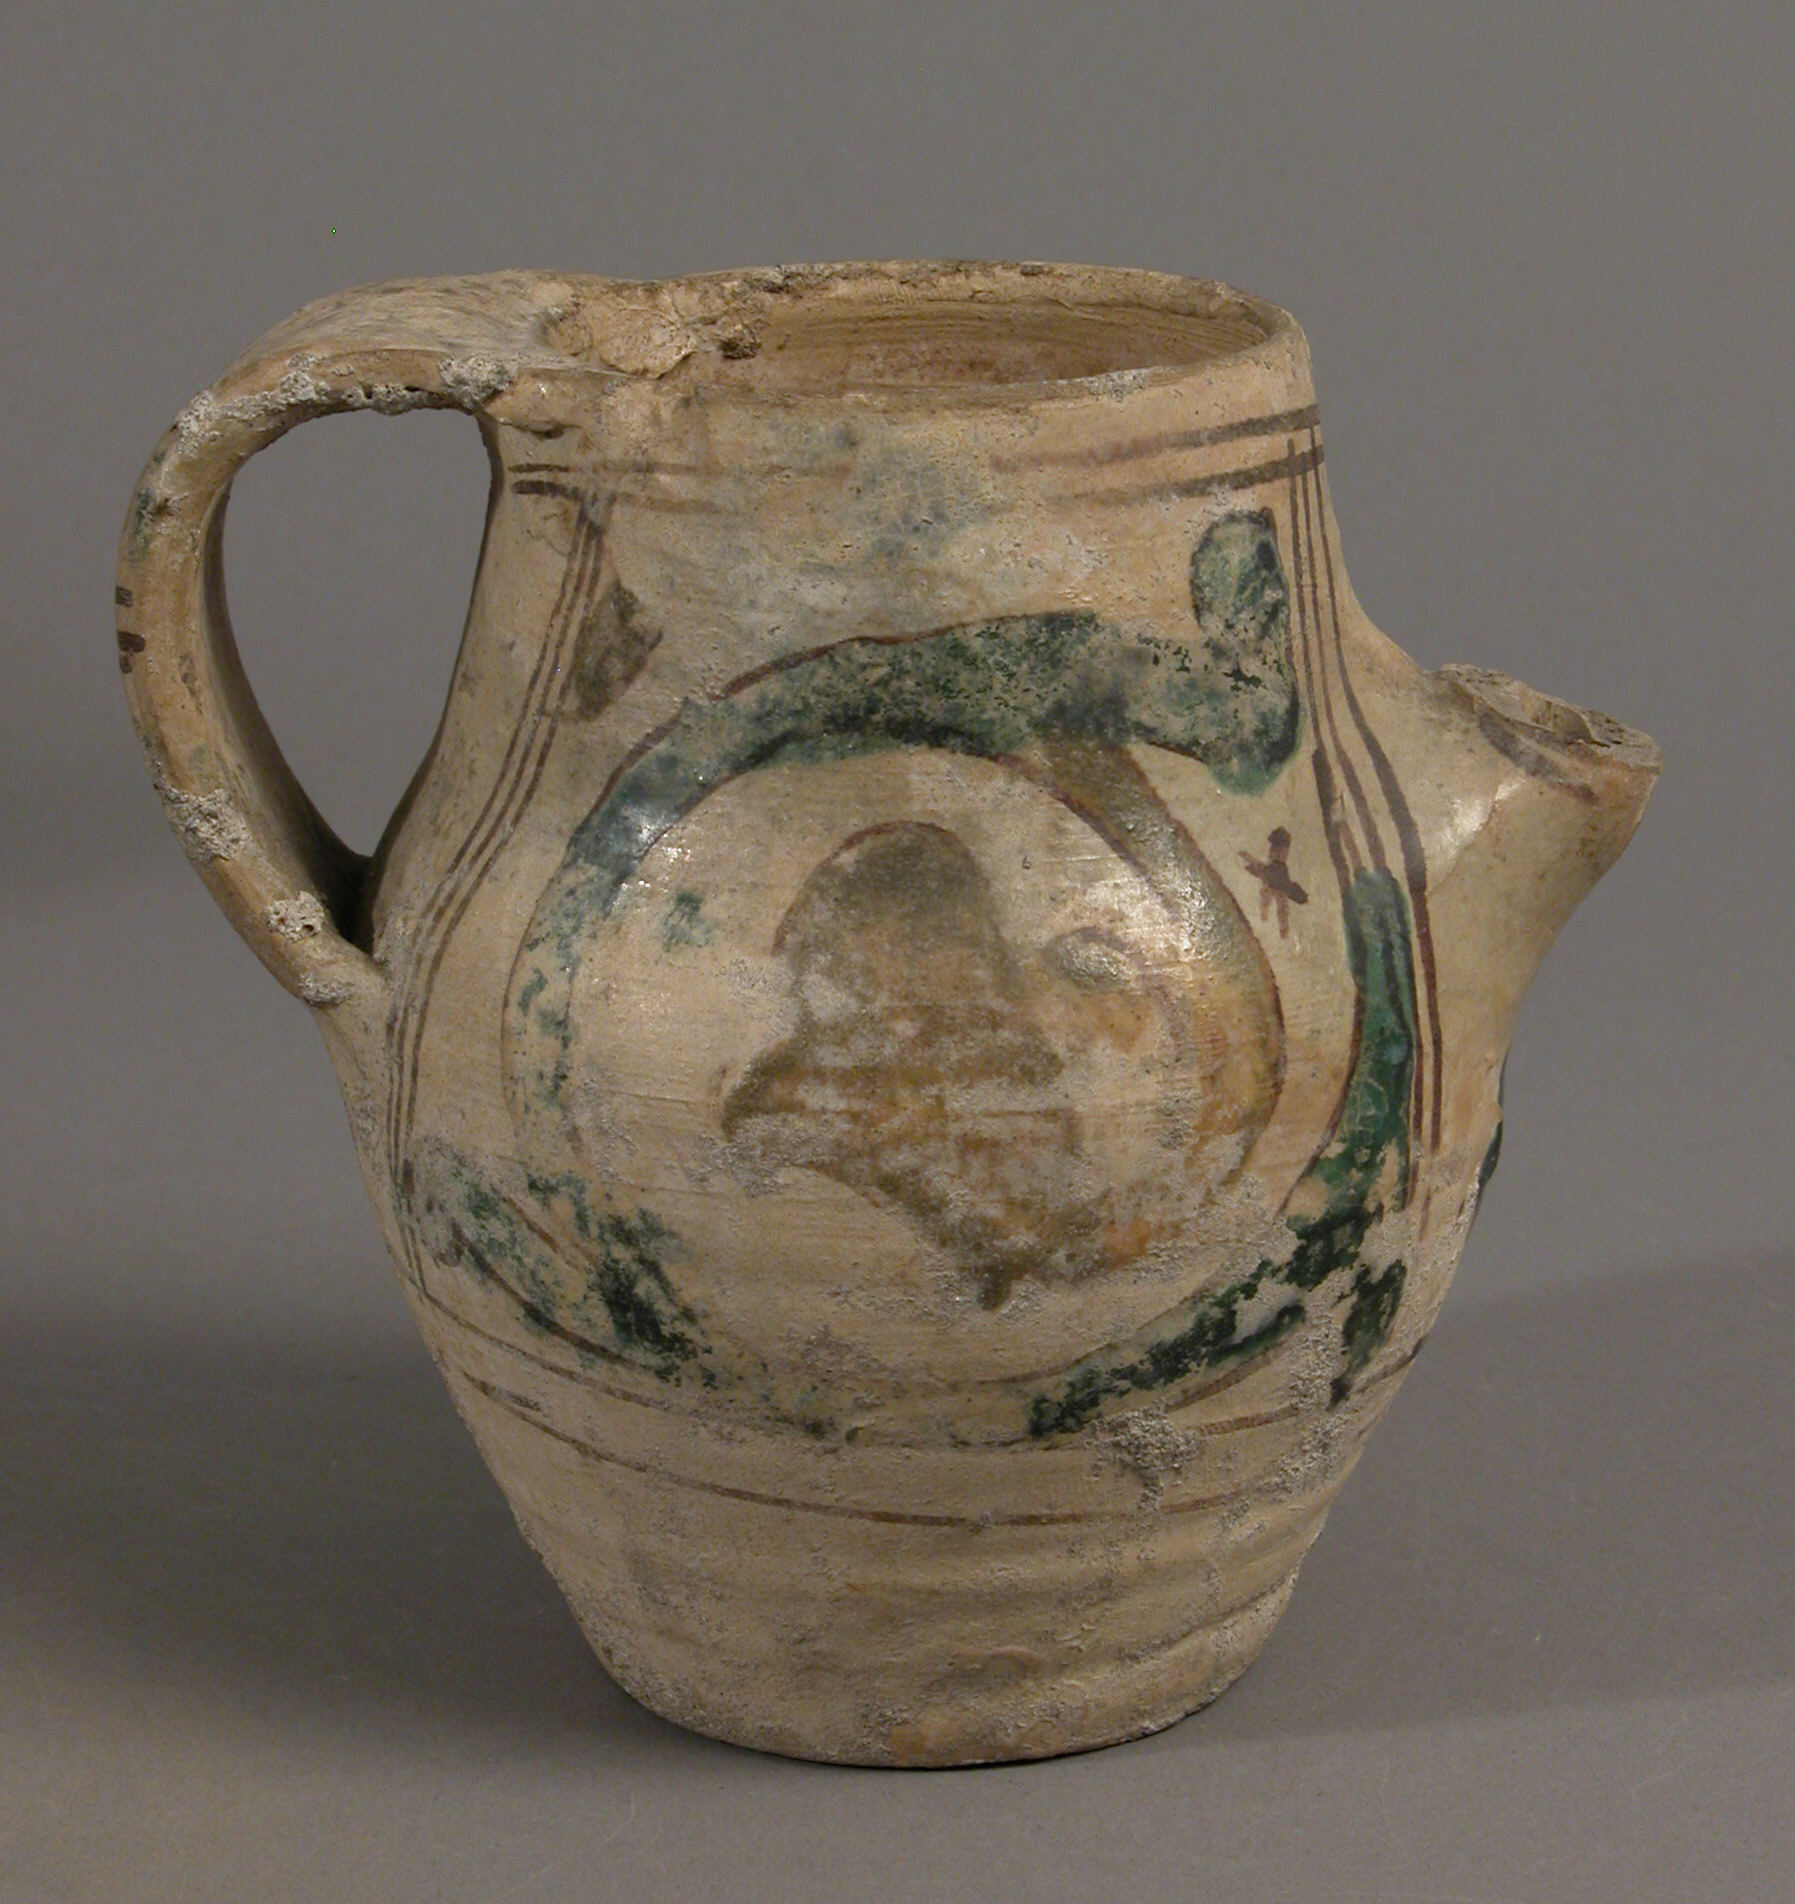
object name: pitcher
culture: italian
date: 1301-1400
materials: earthenware, glaze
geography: italy